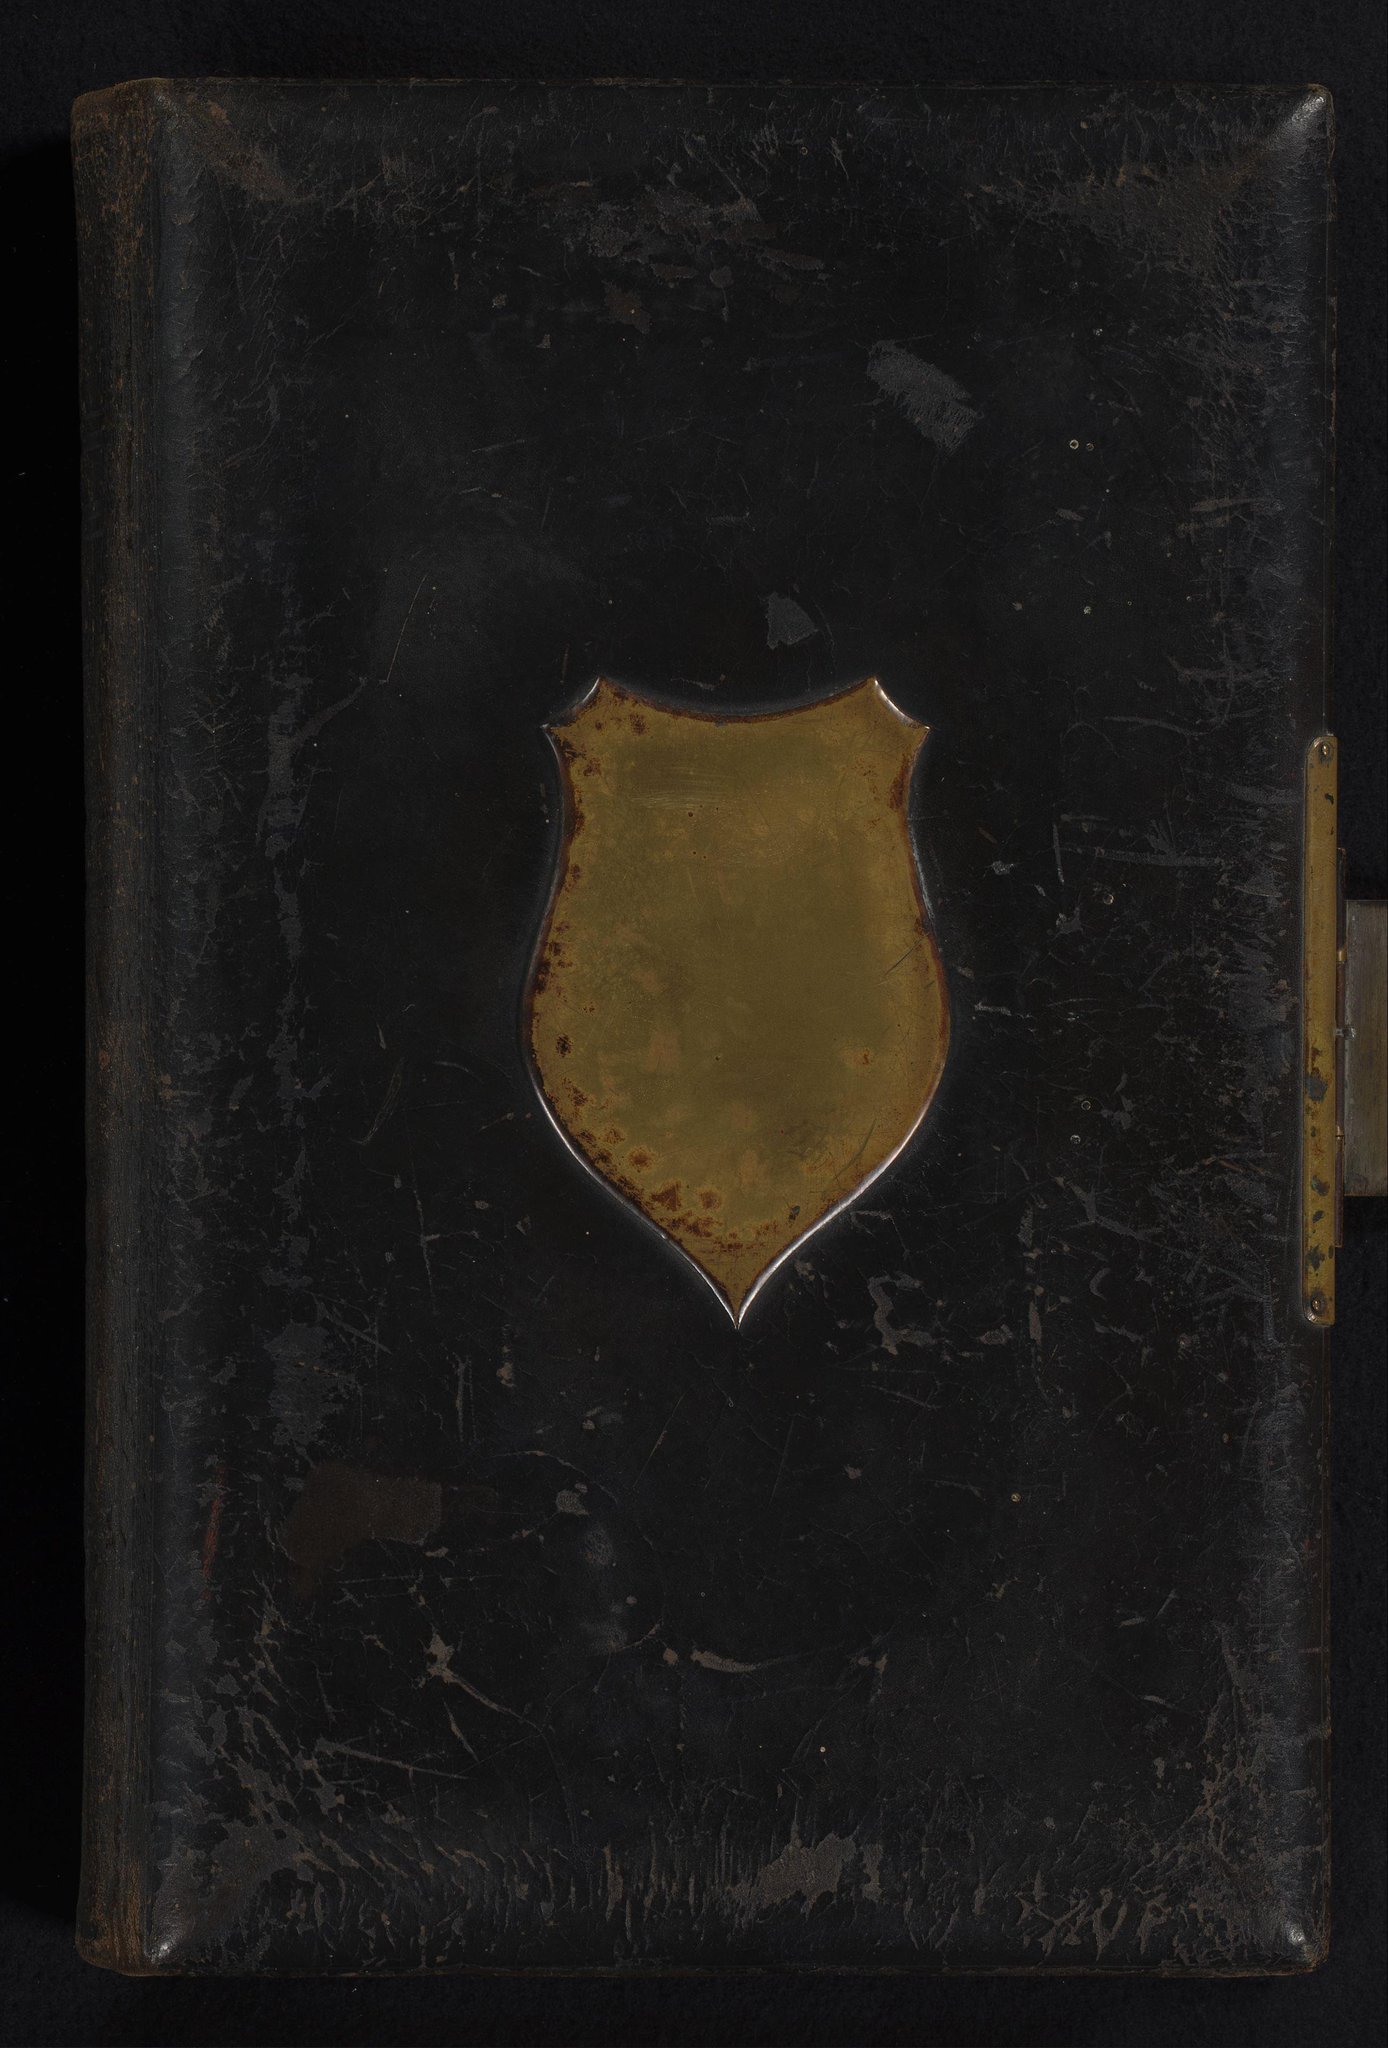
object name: photograph album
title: Fotoalbum met 15 foto's, diverse landen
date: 1870-1920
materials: cardboard, copper, leather, paper, photographic support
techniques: albumen print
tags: historical persons - bb - woman, historical persons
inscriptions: collector's mark: ‘Dienst Verspreide Rijkscollekties/ Inv.nr: A676’, annotation: ‘Br’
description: Fotoalbum met vijftien bladen en vijftien foto's. De foto's zijn vervaardigd in diverse Europese landen door onder andere Fernando Debas, Illario Carposio en Waldemar Dahllhöf. Geportretteerd zijn onder andere Fiede Kugelberg, Gustaf Frederikson en Christine Henriette van Toulon van der Koog Tijdeman.